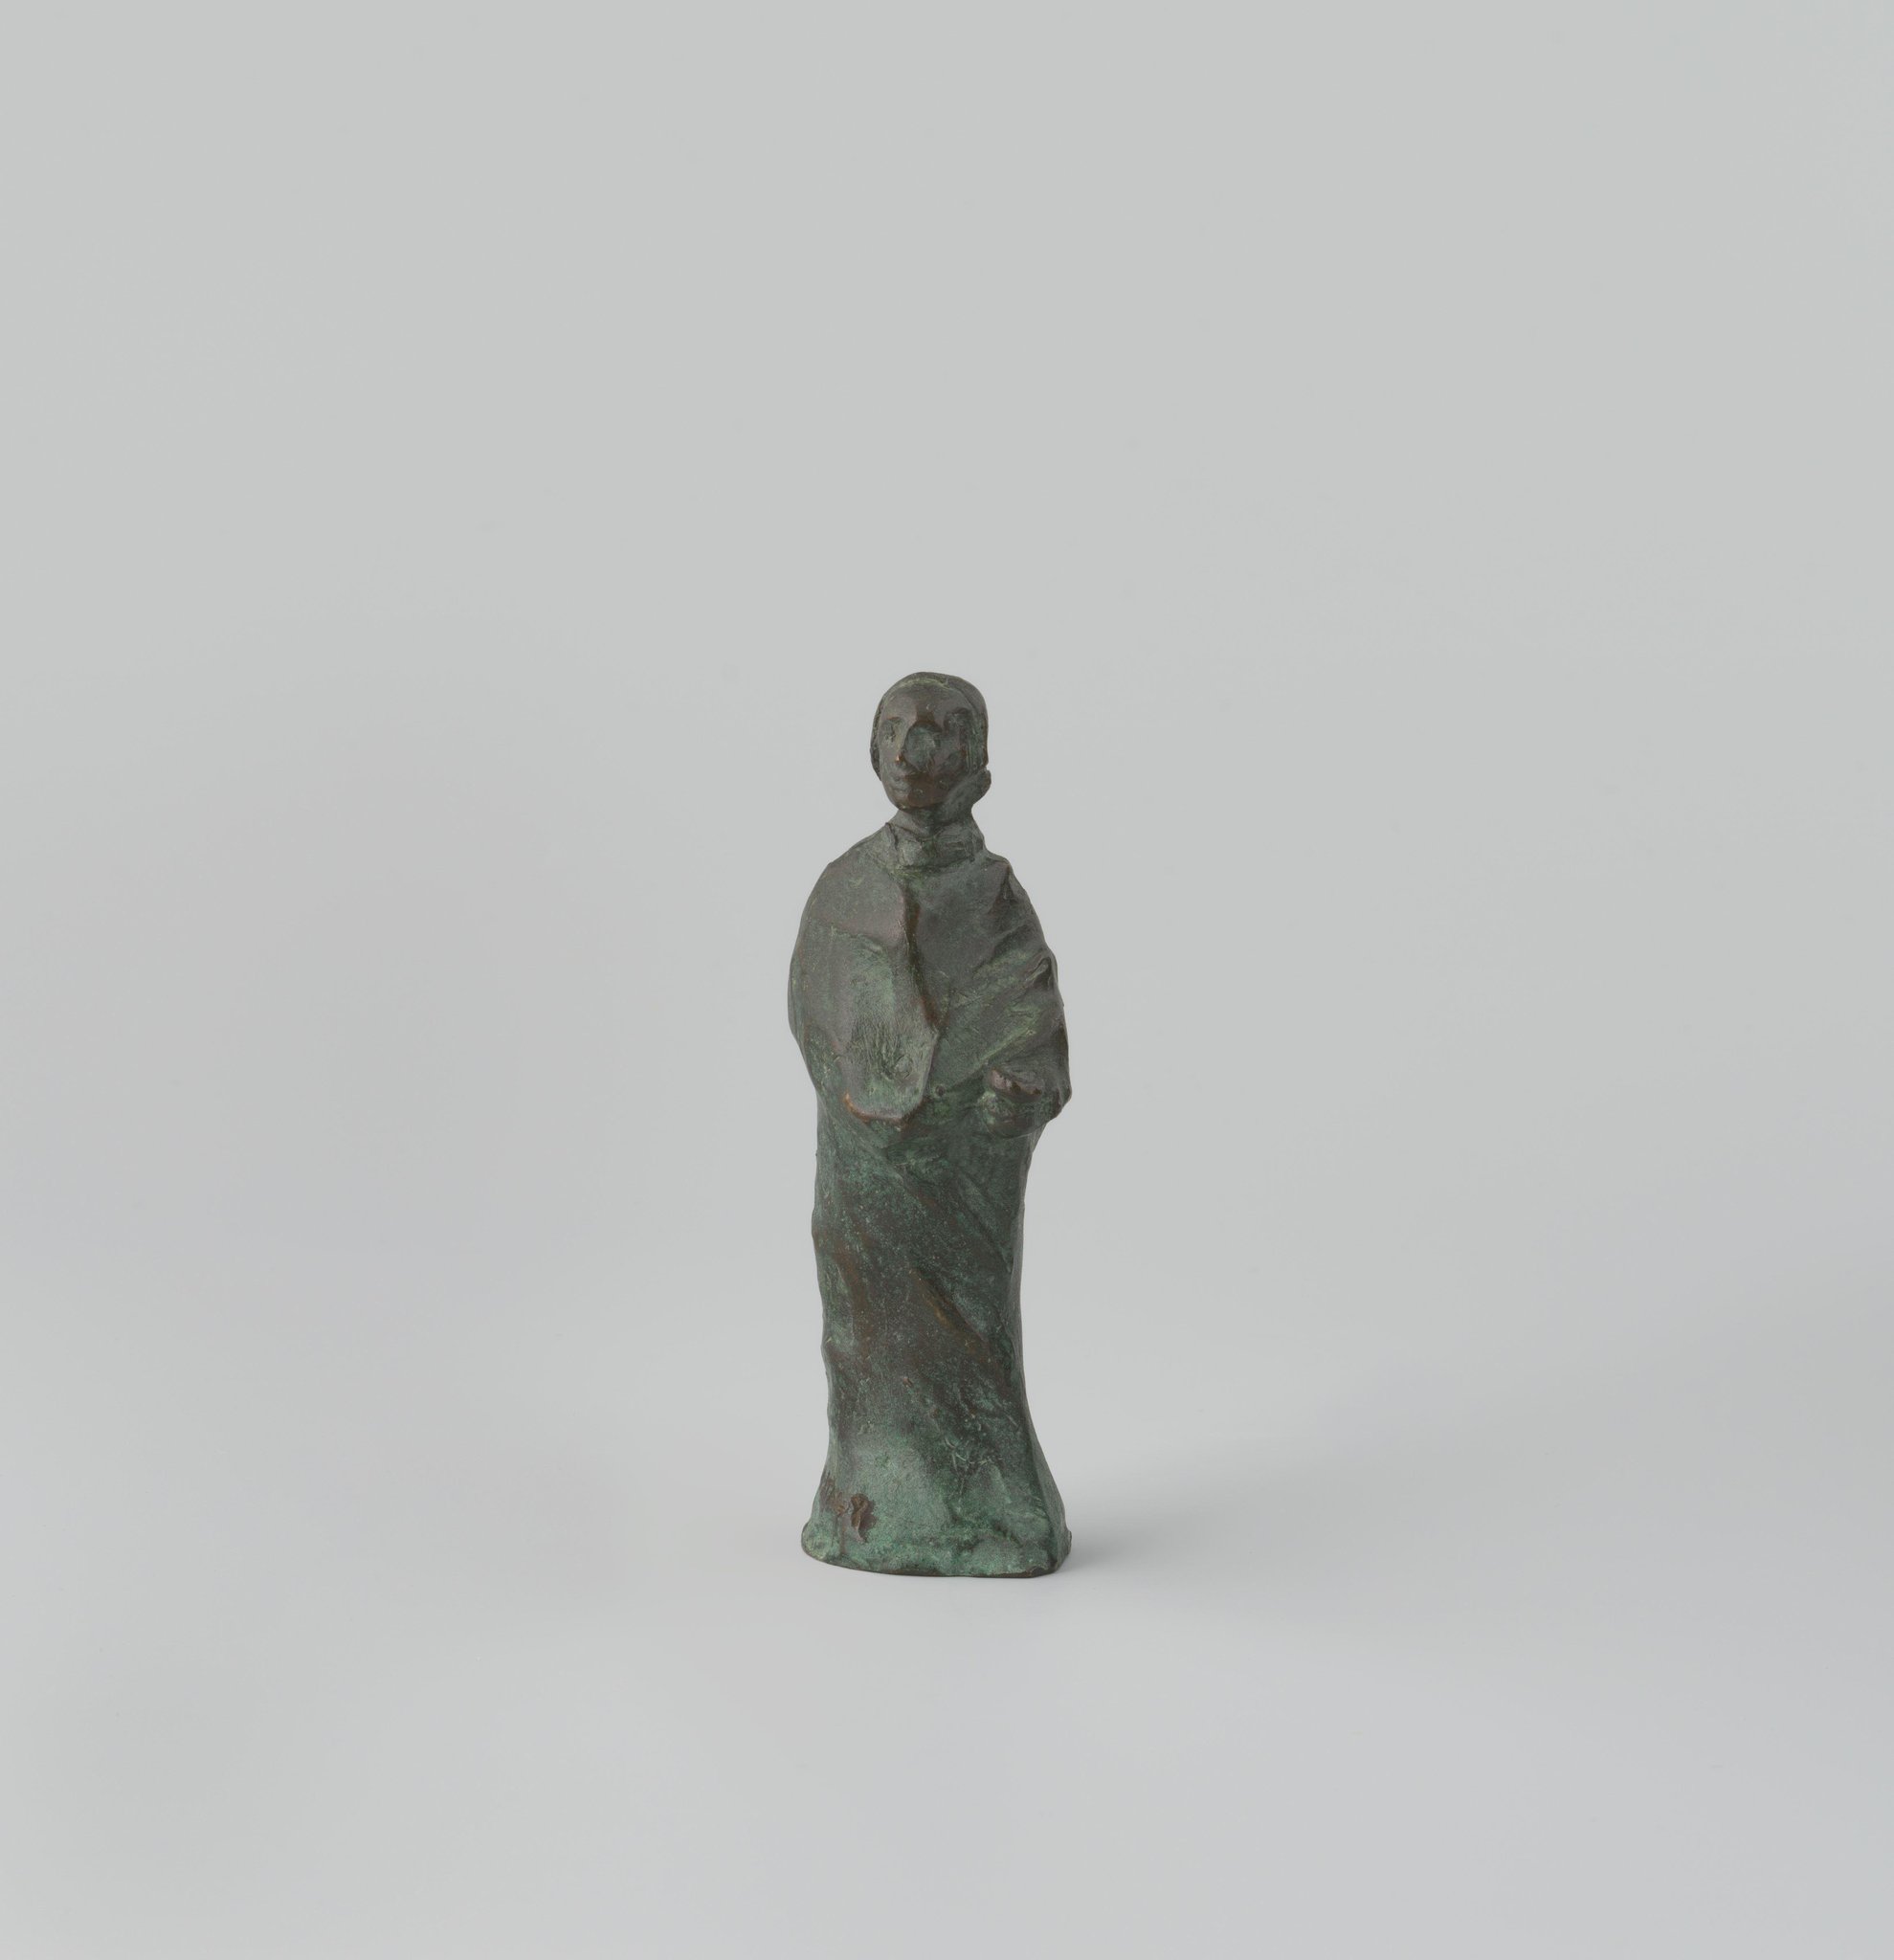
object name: chess piece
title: Pion 3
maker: saar de swart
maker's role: sculptor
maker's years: 1861-1951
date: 1923-1925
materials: bronze, oxide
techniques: casting, lost wax process, patinaed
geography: capri